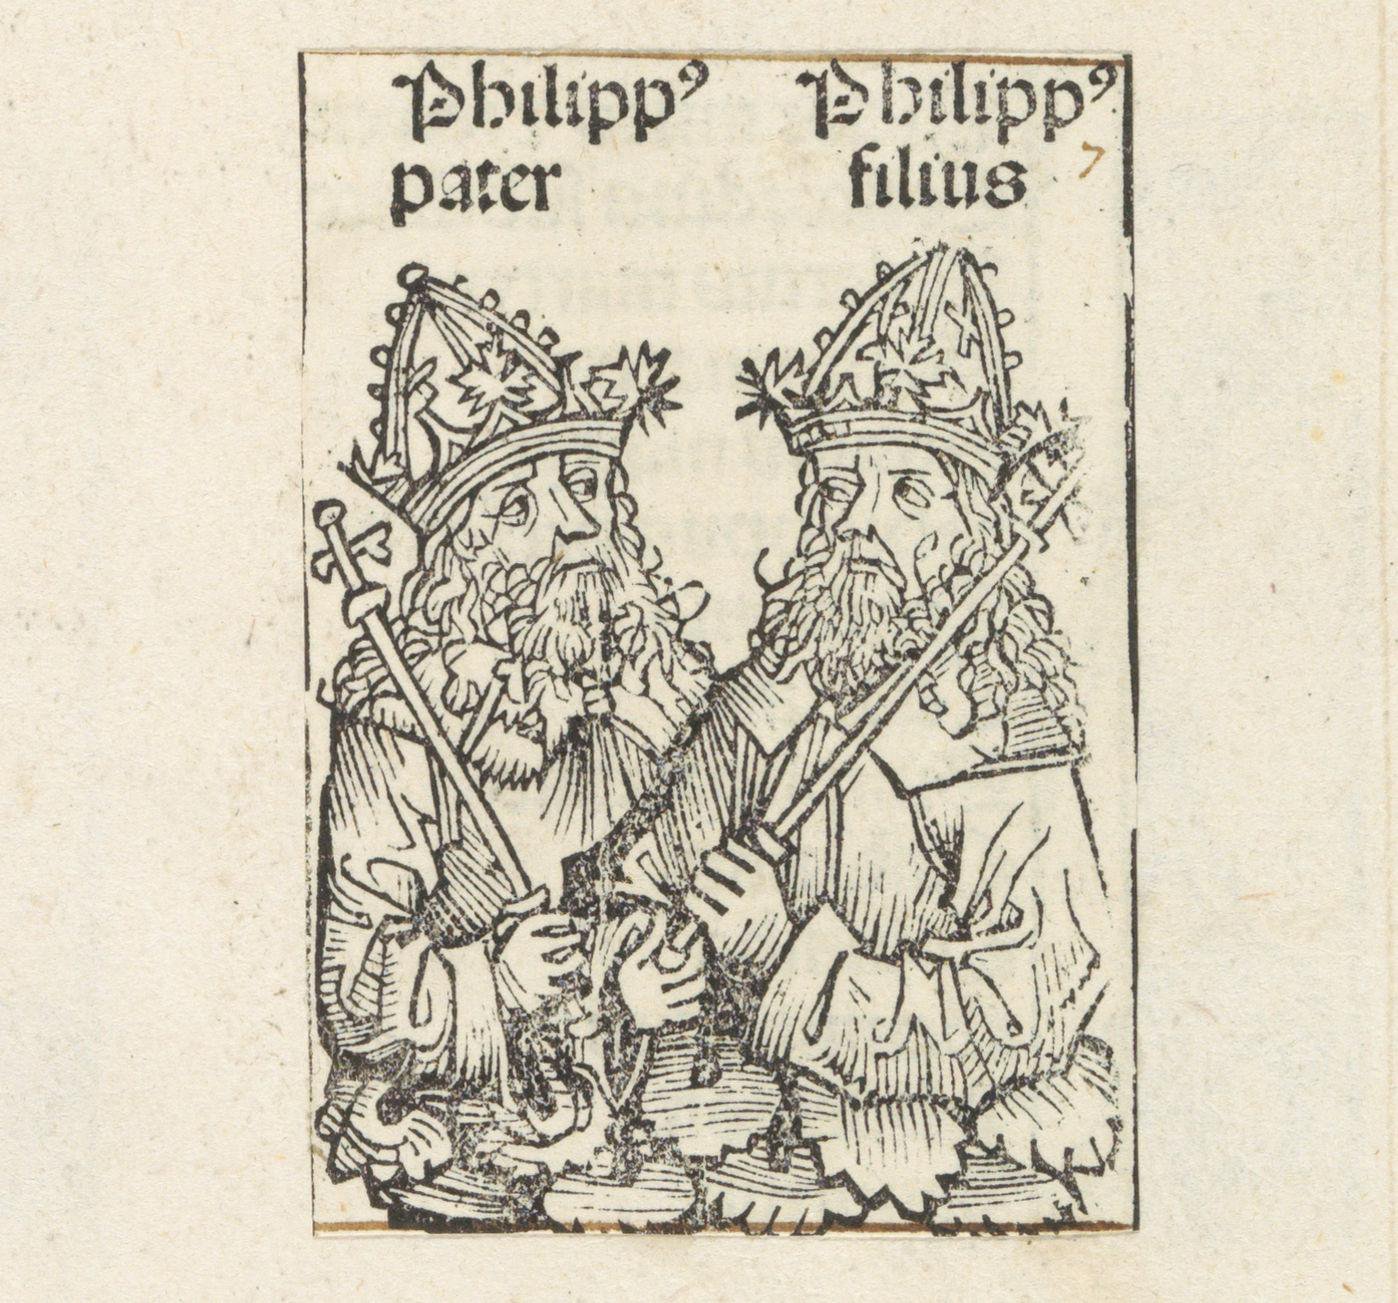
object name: album leaf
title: Philipp[us] pater / Philipp[us] filius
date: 1493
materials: paper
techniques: letterpress printing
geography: nuremberg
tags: emperor, king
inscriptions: inscription: ‘7’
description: Een bloemkelk met twee koningen. In hun handen hebben zij een scepter. De voorstelling is onderdeel van de opeenvolging Romeinse keizers in de Liber Chronicarum. De tekst identificeert de man als keizer Philippus I Arabs en zijn zoon Philippus II. De prent maakt deel uit van een album.